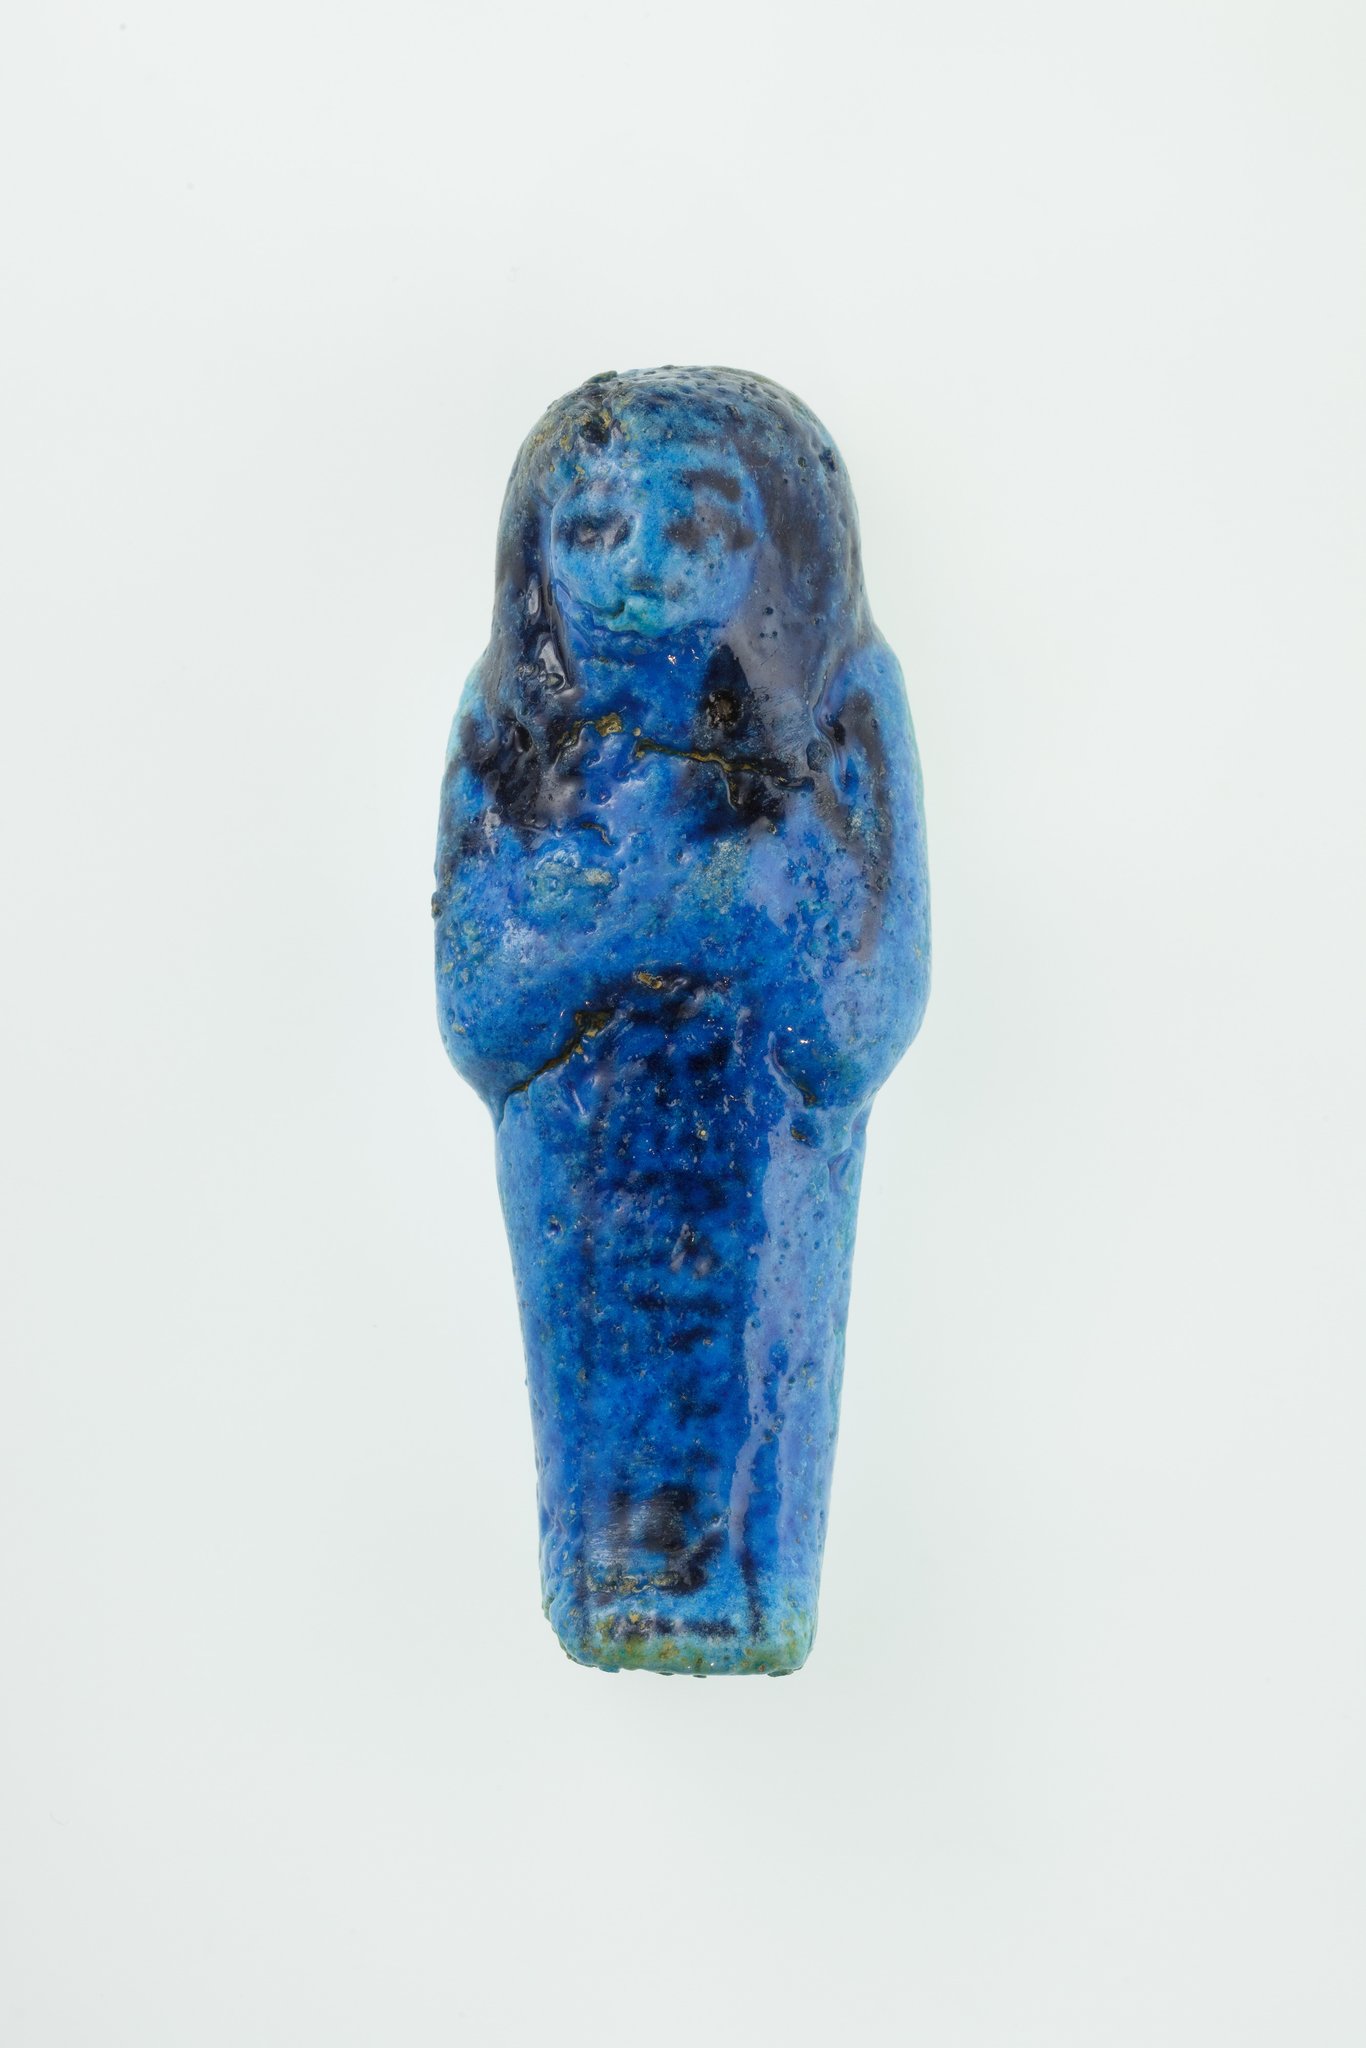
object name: shabti, worker, nauny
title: Worker Shabti of Nauny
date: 1050 BCE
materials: faience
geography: egypt